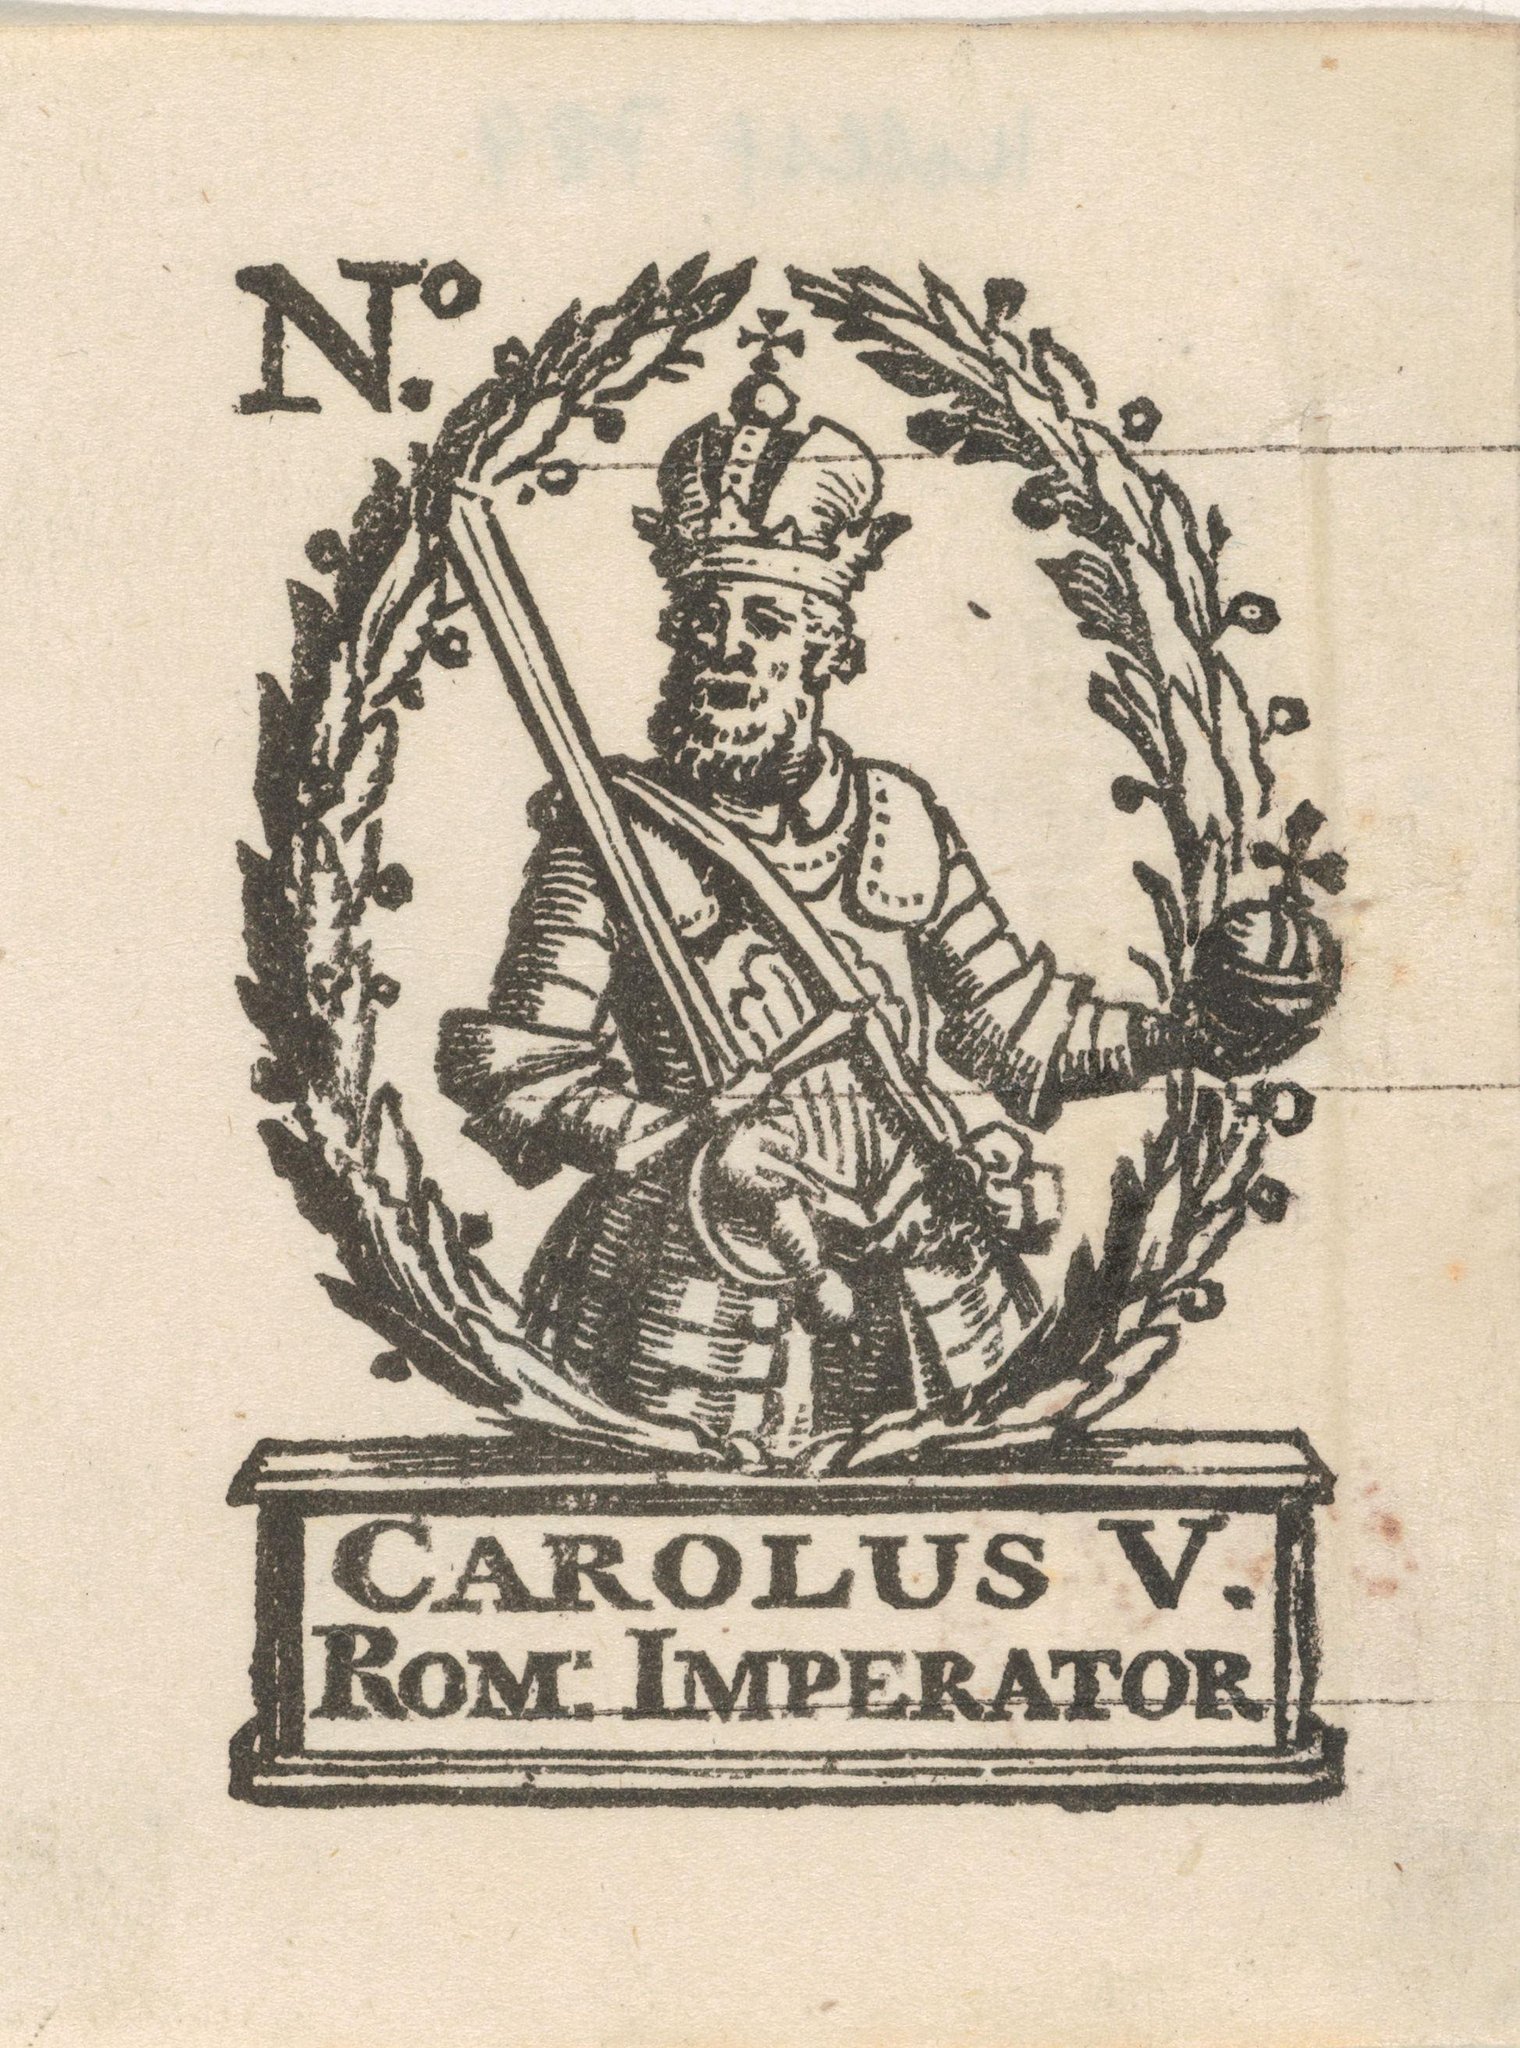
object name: print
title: Carolus V. Rom: Imperator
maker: isaac vincentsz. van der vinne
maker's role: draughtsman, print maker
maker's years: 1665-1740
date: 1681-1740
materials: paper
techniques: woodcut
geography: haarlem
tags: emperor, vignette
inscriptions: collector's mark: Lugt 240